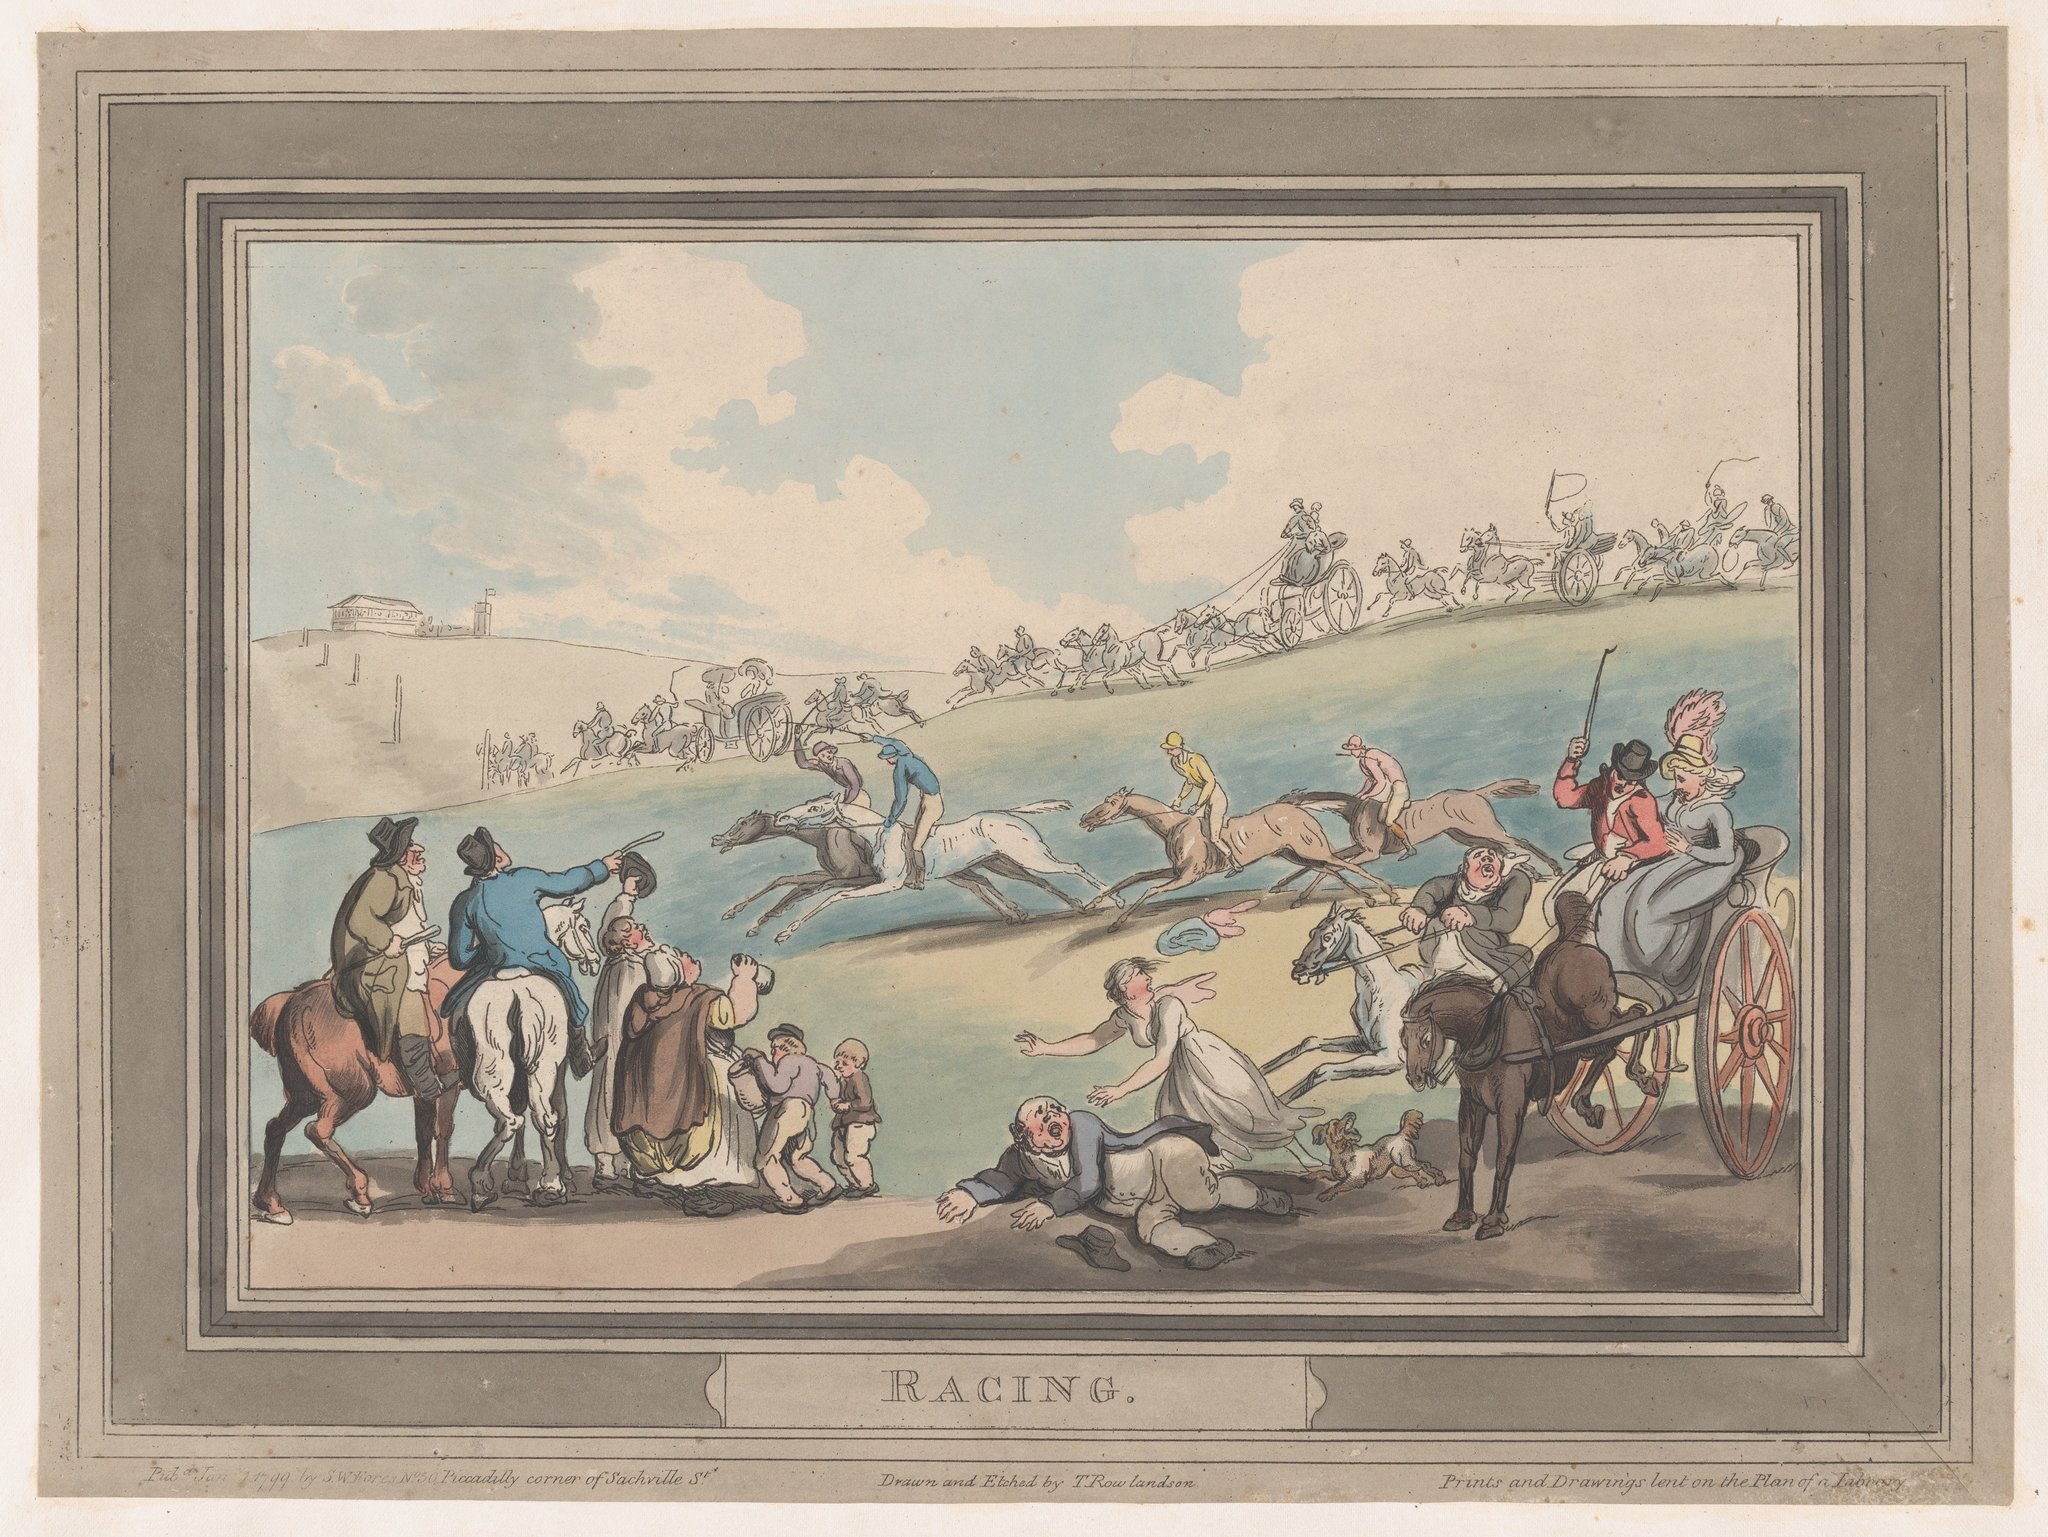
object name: print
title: Racing [The Start]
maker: thomas rowlandson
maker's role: artist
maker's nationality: british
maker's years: 1757-1827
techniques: etching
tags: satire,men,women,horses,carriages